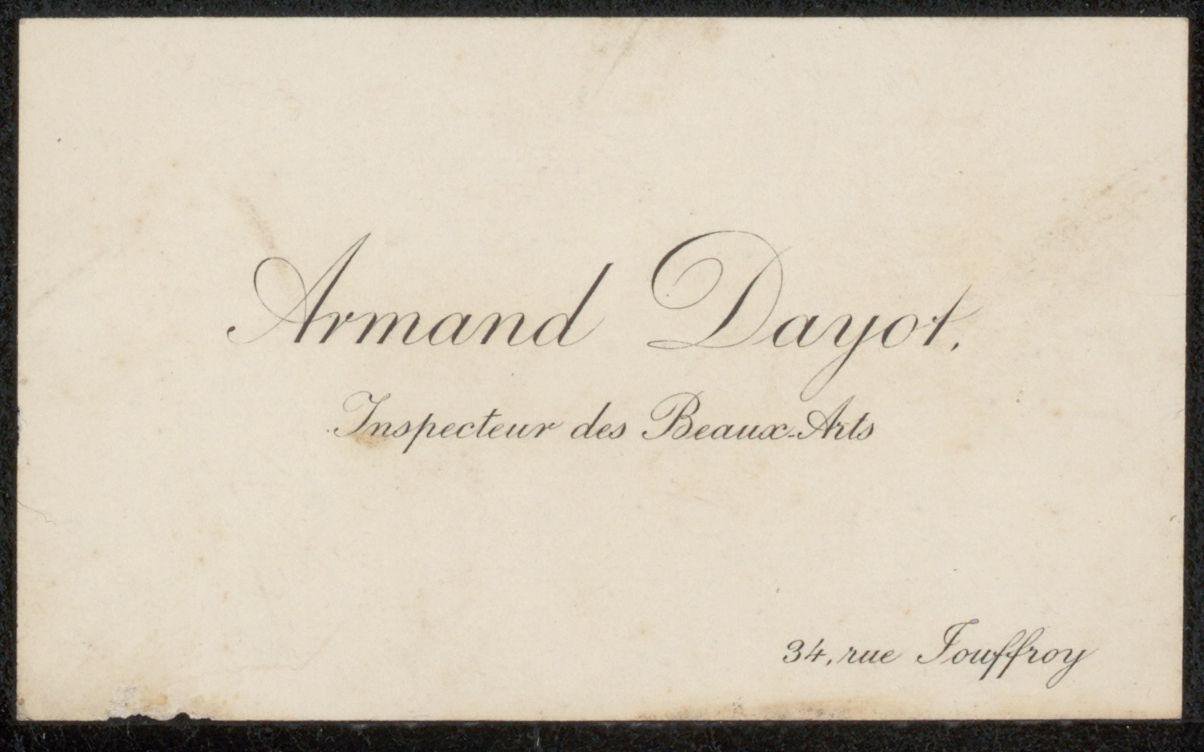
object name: visiting card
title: Visitekaartje aan Philip Zicken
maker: armand dayot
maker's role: historicus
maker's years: 1851-1934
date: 1867-1930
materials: cardboard, ink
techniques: printing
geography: paris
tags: painter, draughtsman, philip zilcken